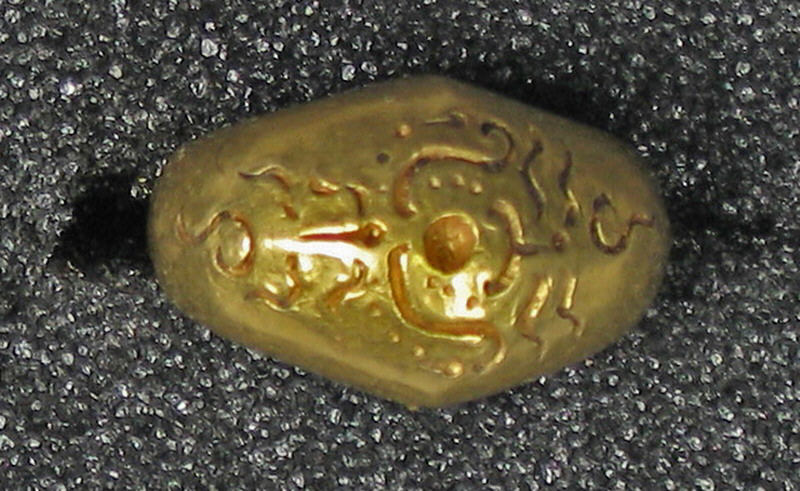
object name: ring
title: Ring with Rounded Bezel, Floral Design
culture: indonesian, central java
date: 701-1200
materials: gold